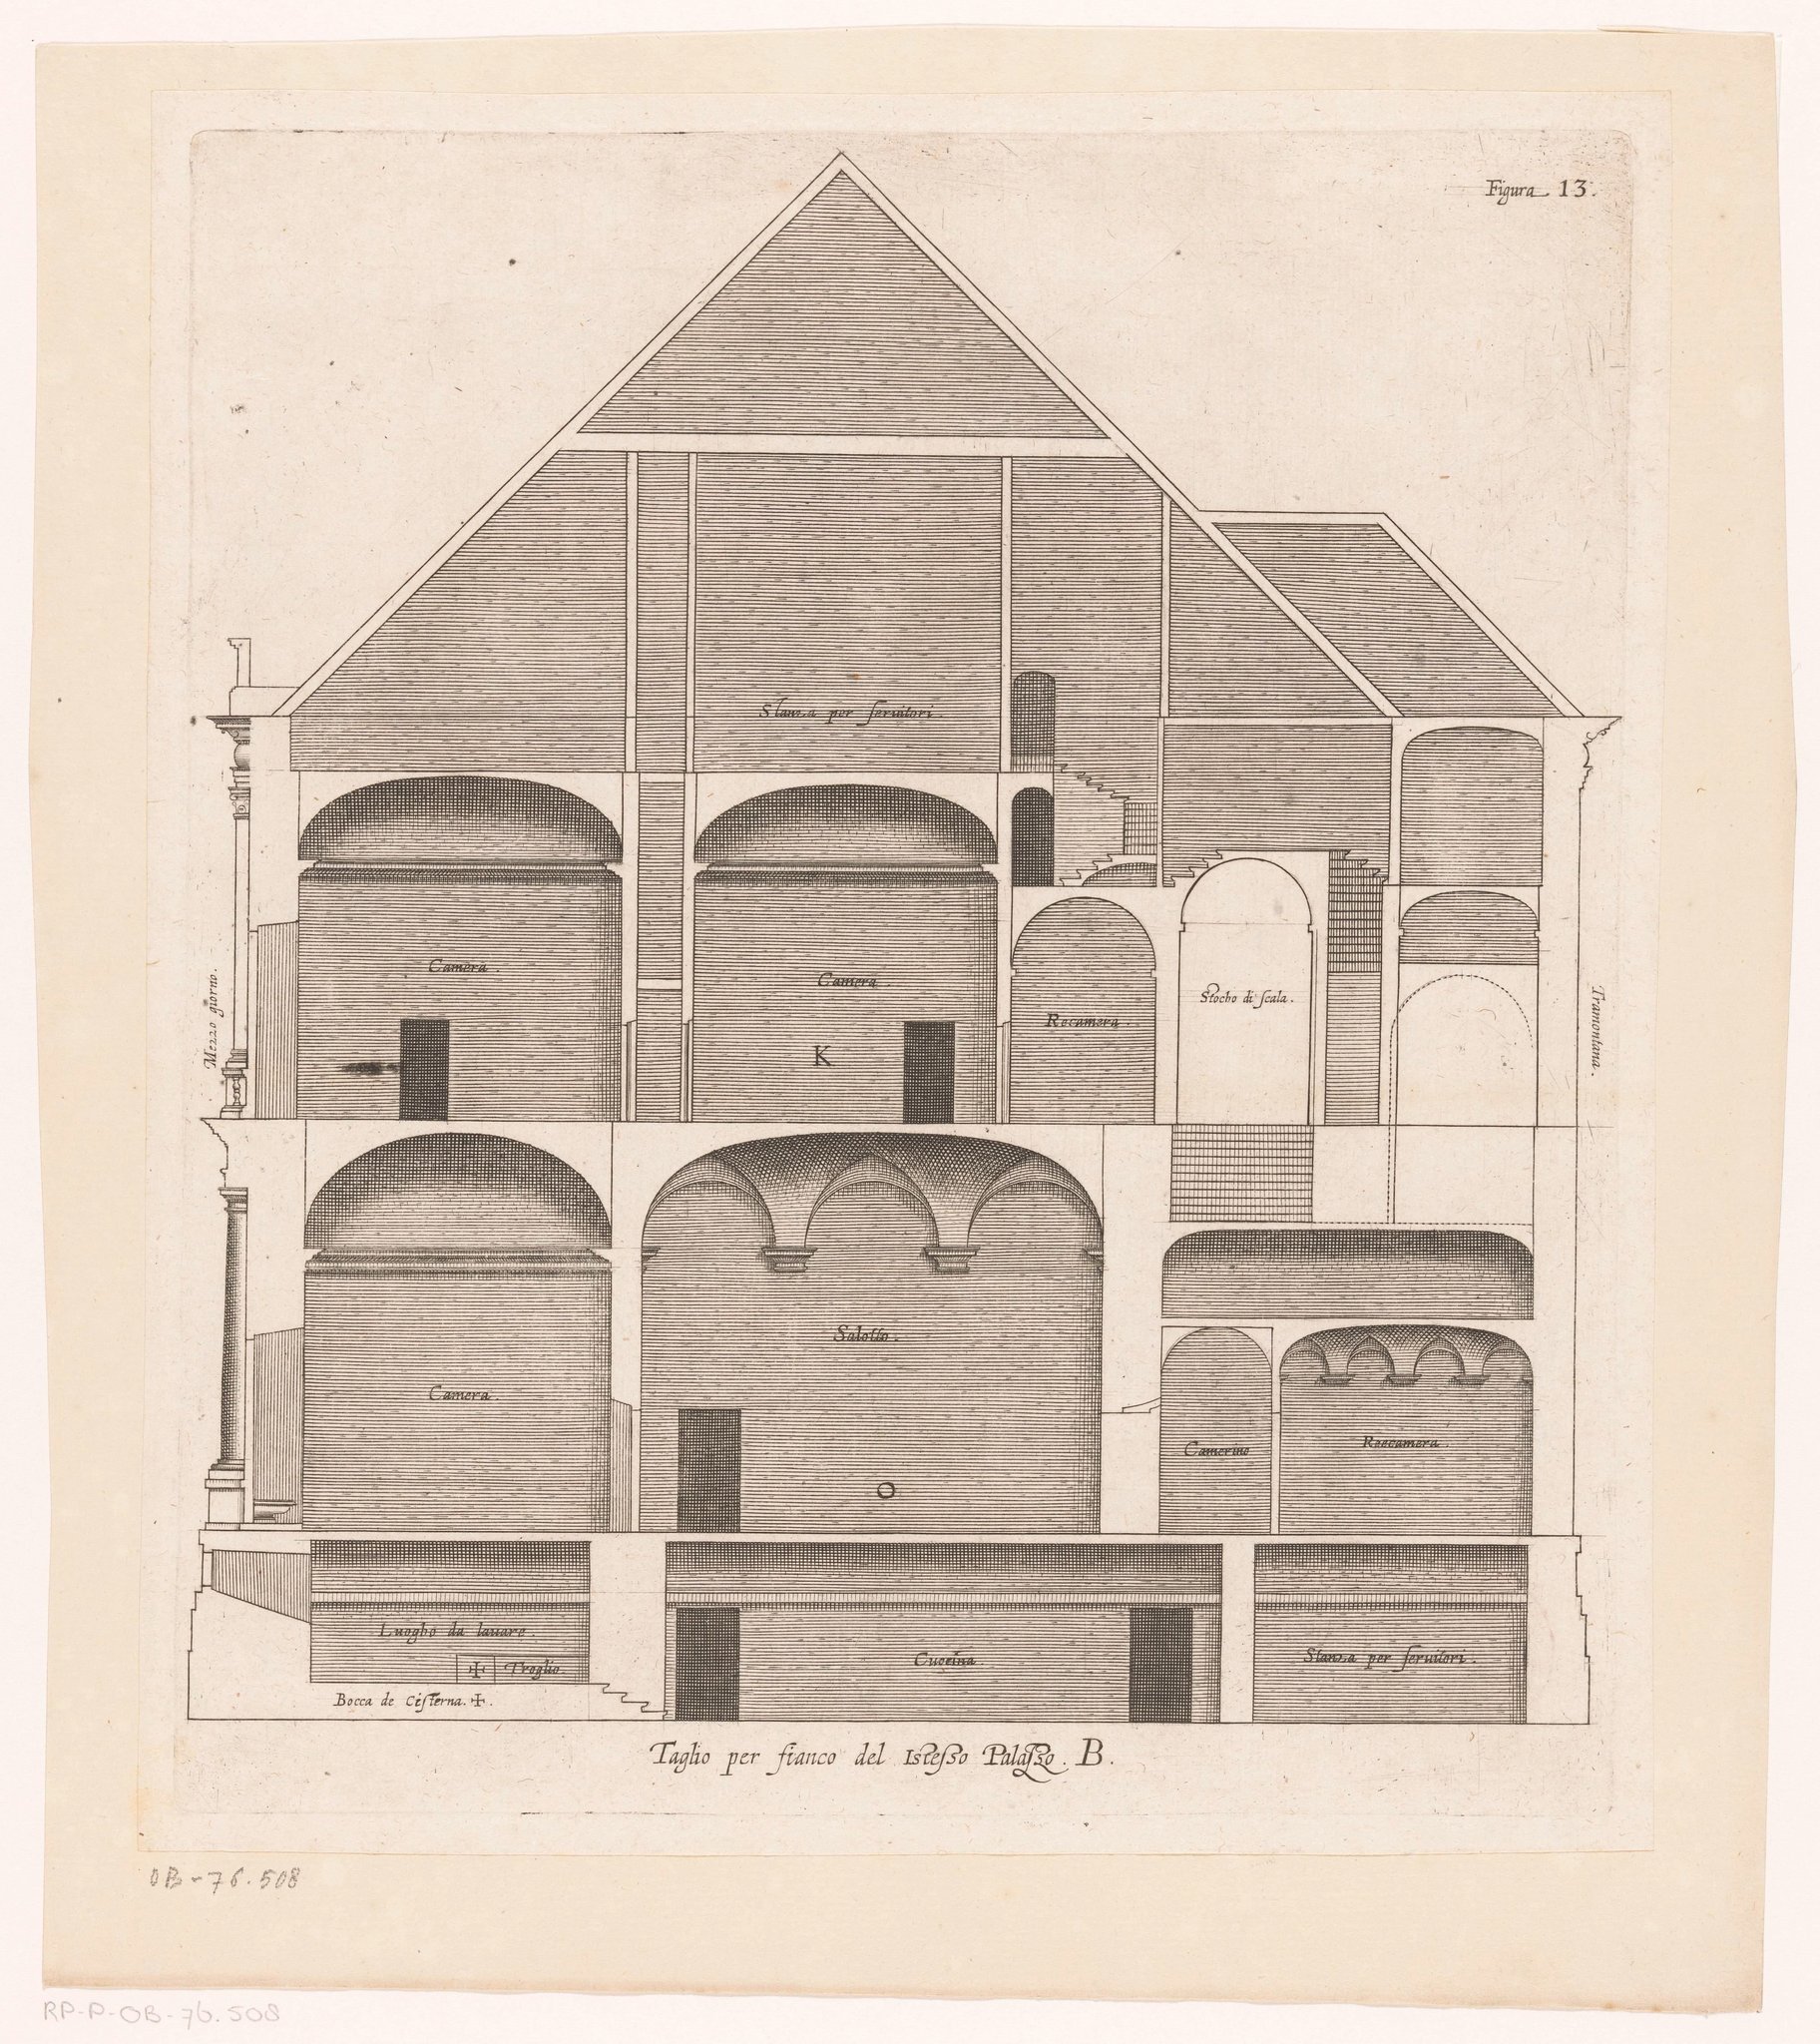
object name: print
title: Palazzi di Genova / Palazzi Antichi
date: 1622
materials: paper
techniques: engraving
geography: antwerp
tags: hôtel, i.e. small palace in city - aa - civic architecture: inside, section ~ architectural design or model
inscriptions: collector's mark: Lugt 240